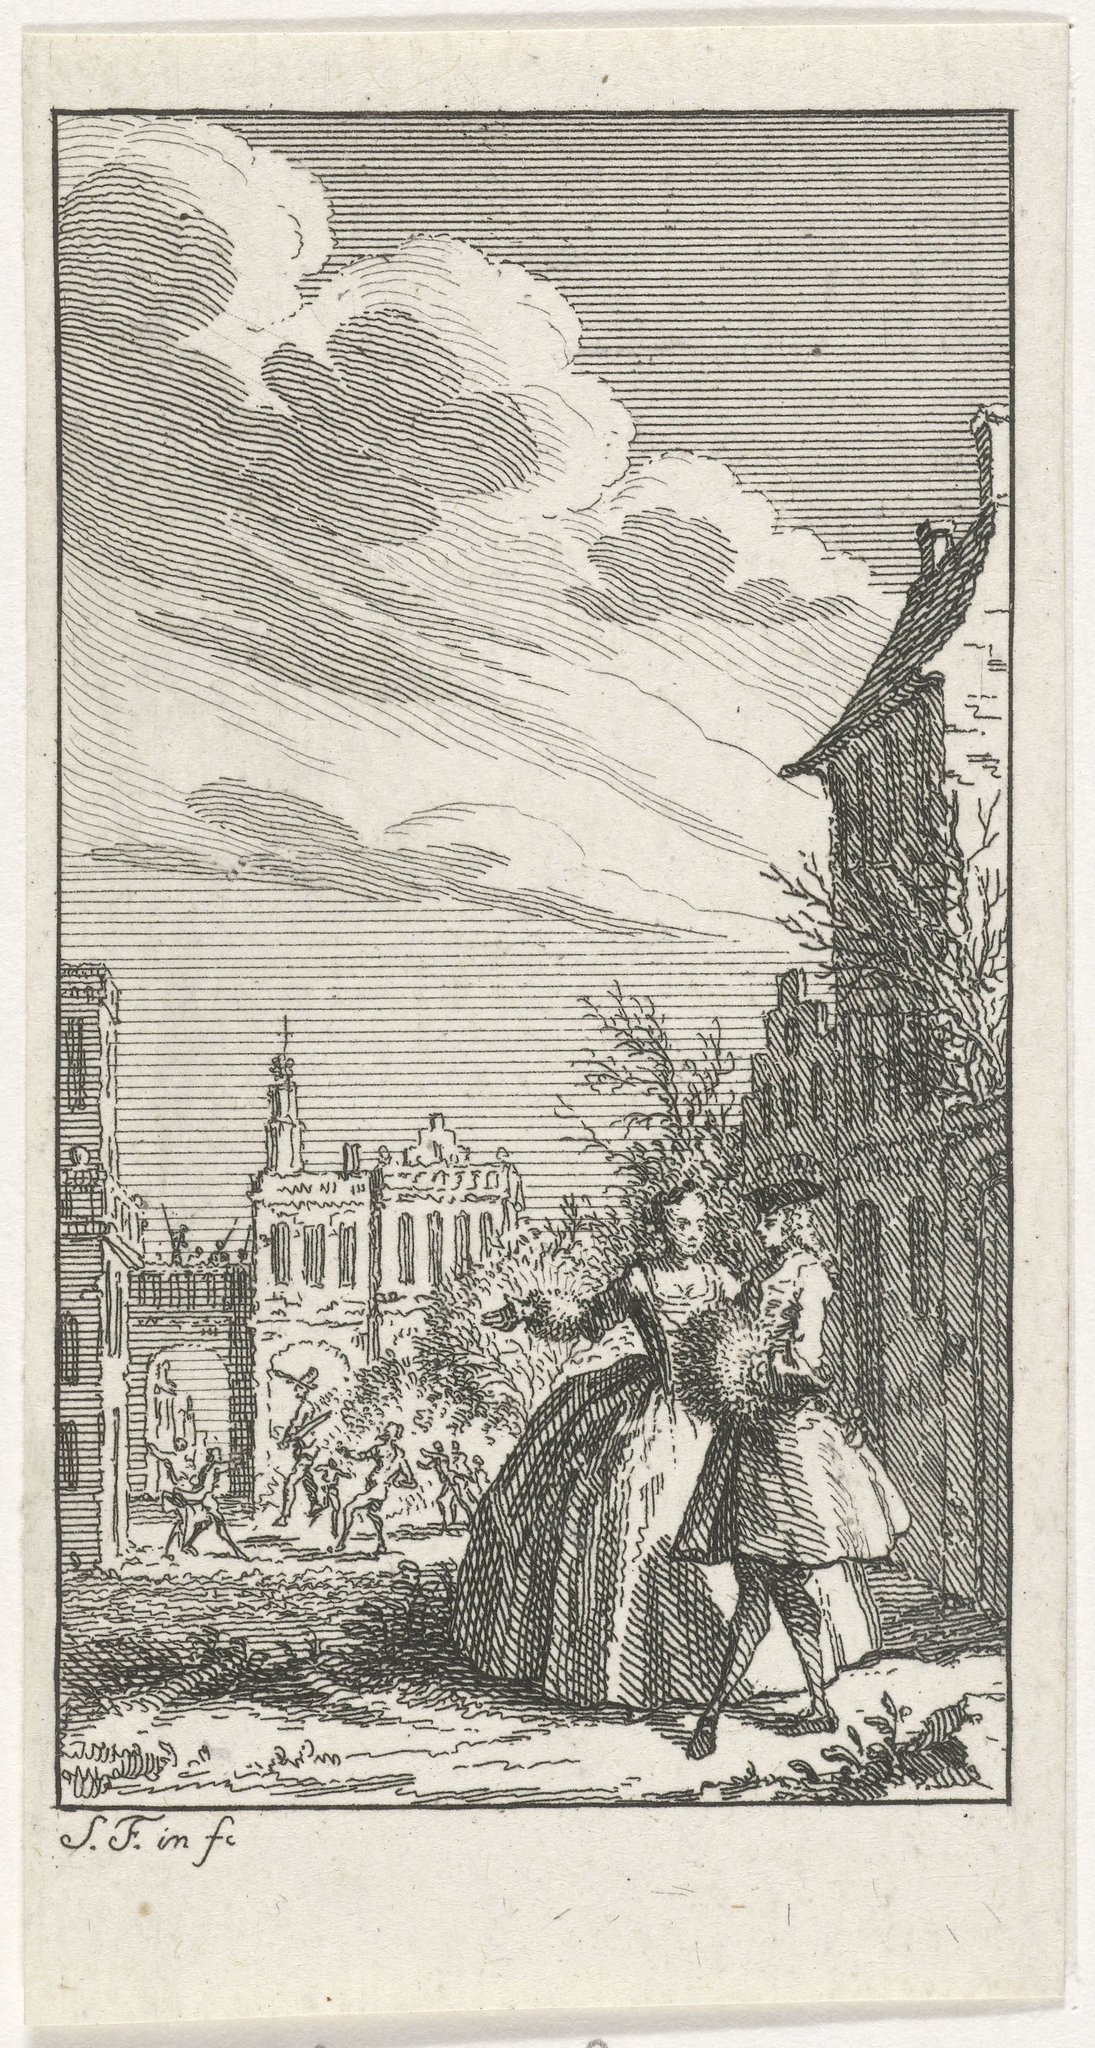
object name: print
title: De twaalf maanden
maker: simon fokke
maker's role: draughtsman, print maker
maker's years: 1712-1784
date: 1722-1784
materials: paper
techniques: etching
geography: amsterdam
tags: february ~ other concepts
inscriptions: collector's mark: Lugt 240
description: Uit een serie van twaalf prenten, de verbeelding van de maand februari. Oproer in een straat met op de voorgrond een welgesteld echtpaar.